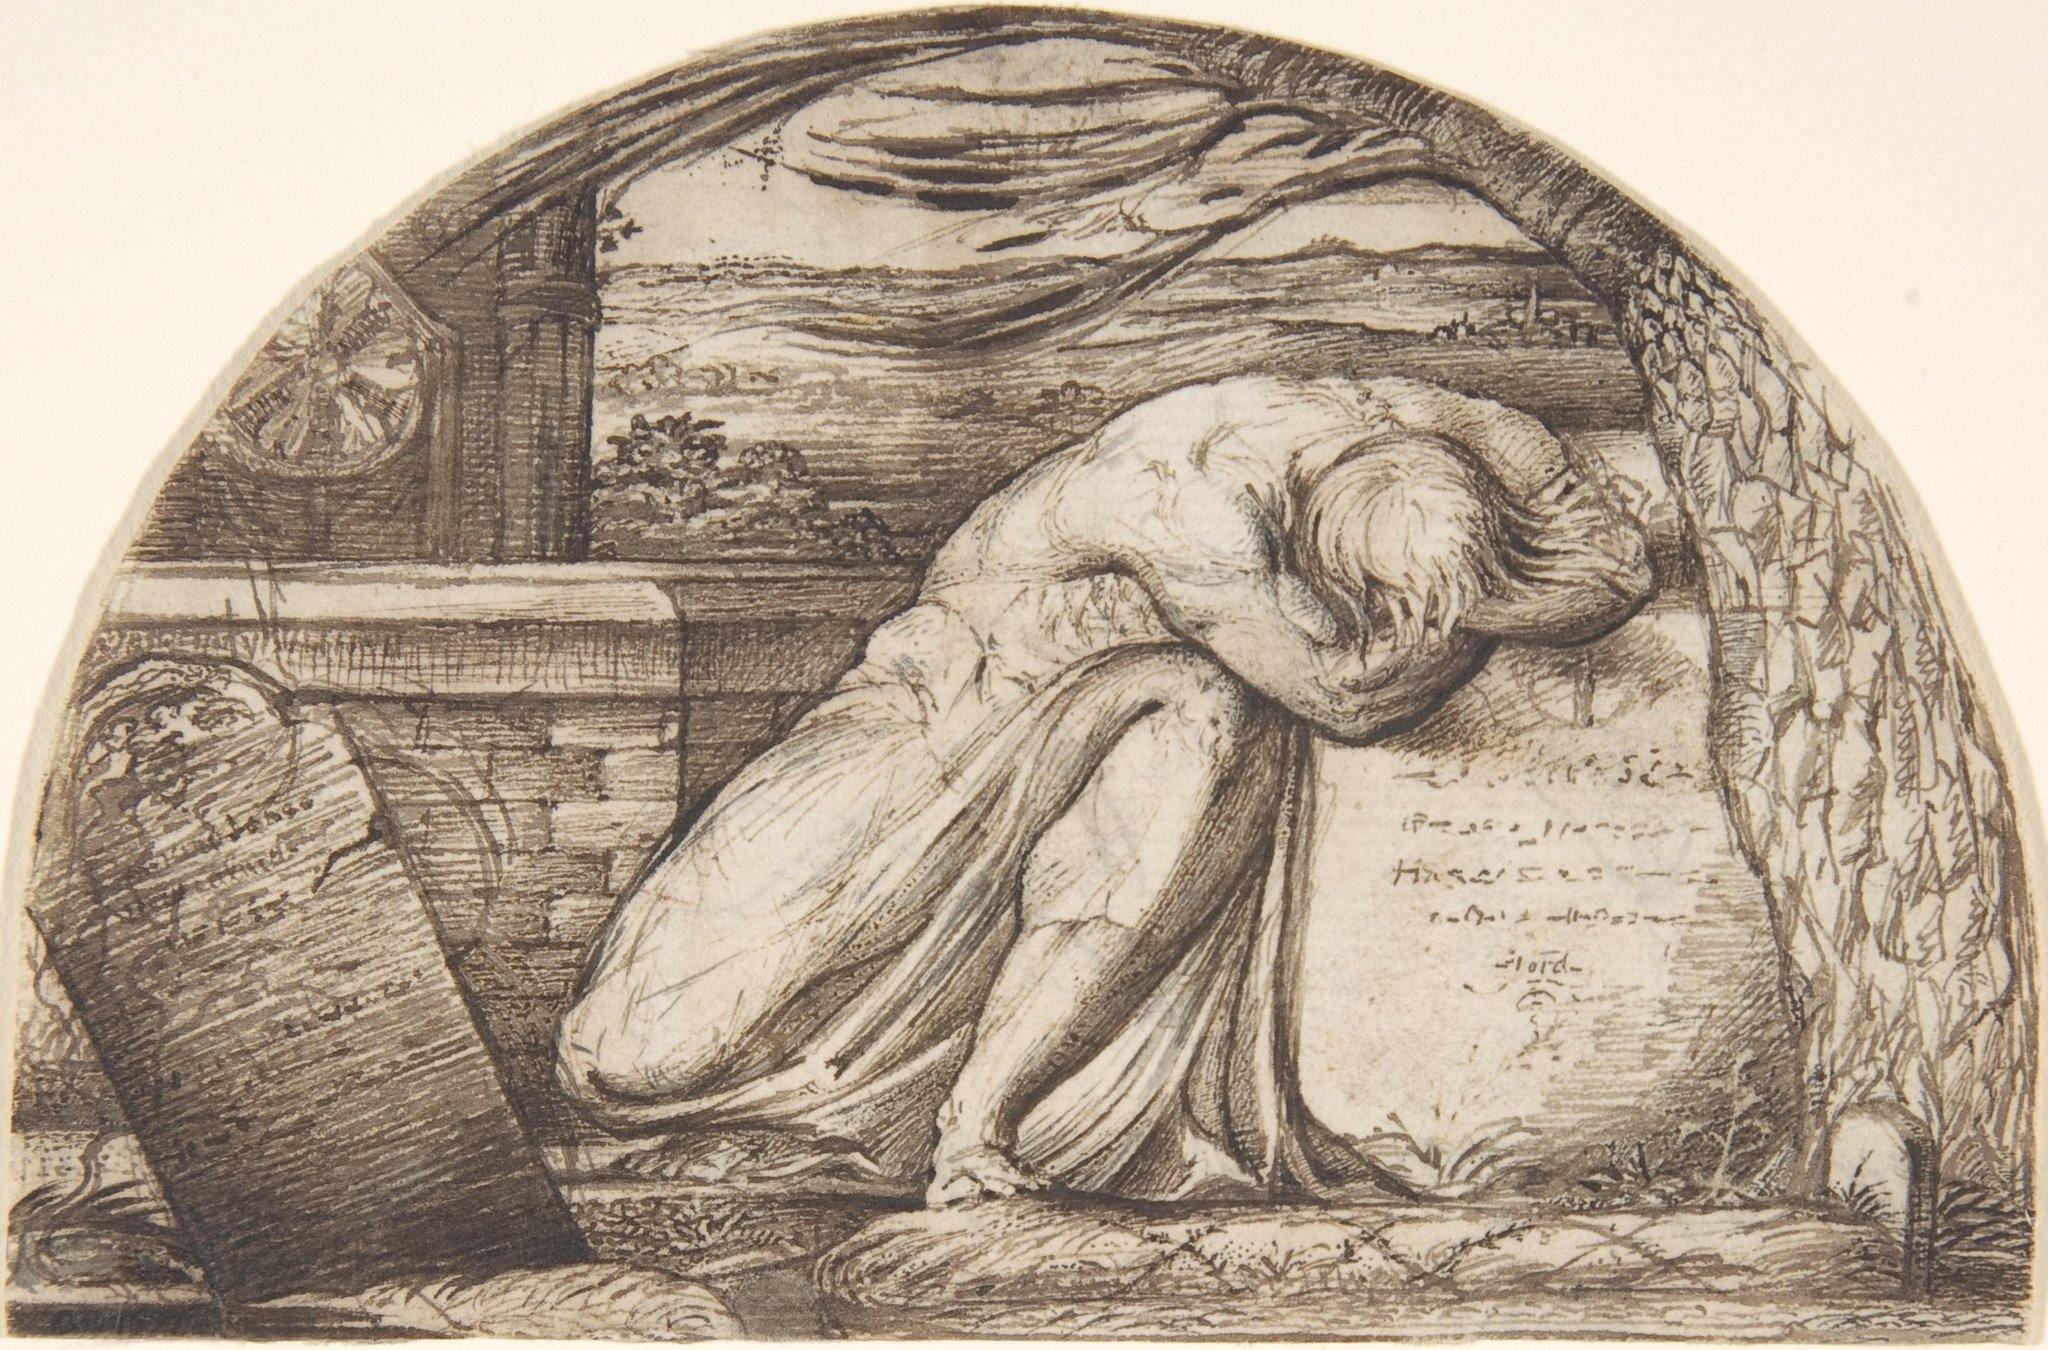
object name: drawing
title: A figure weeping over a grave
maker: george richmond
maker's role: artist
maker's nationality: british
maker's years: 1809-1896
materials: graphite, ink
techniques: pen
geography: united kingdom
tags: human figures,burials